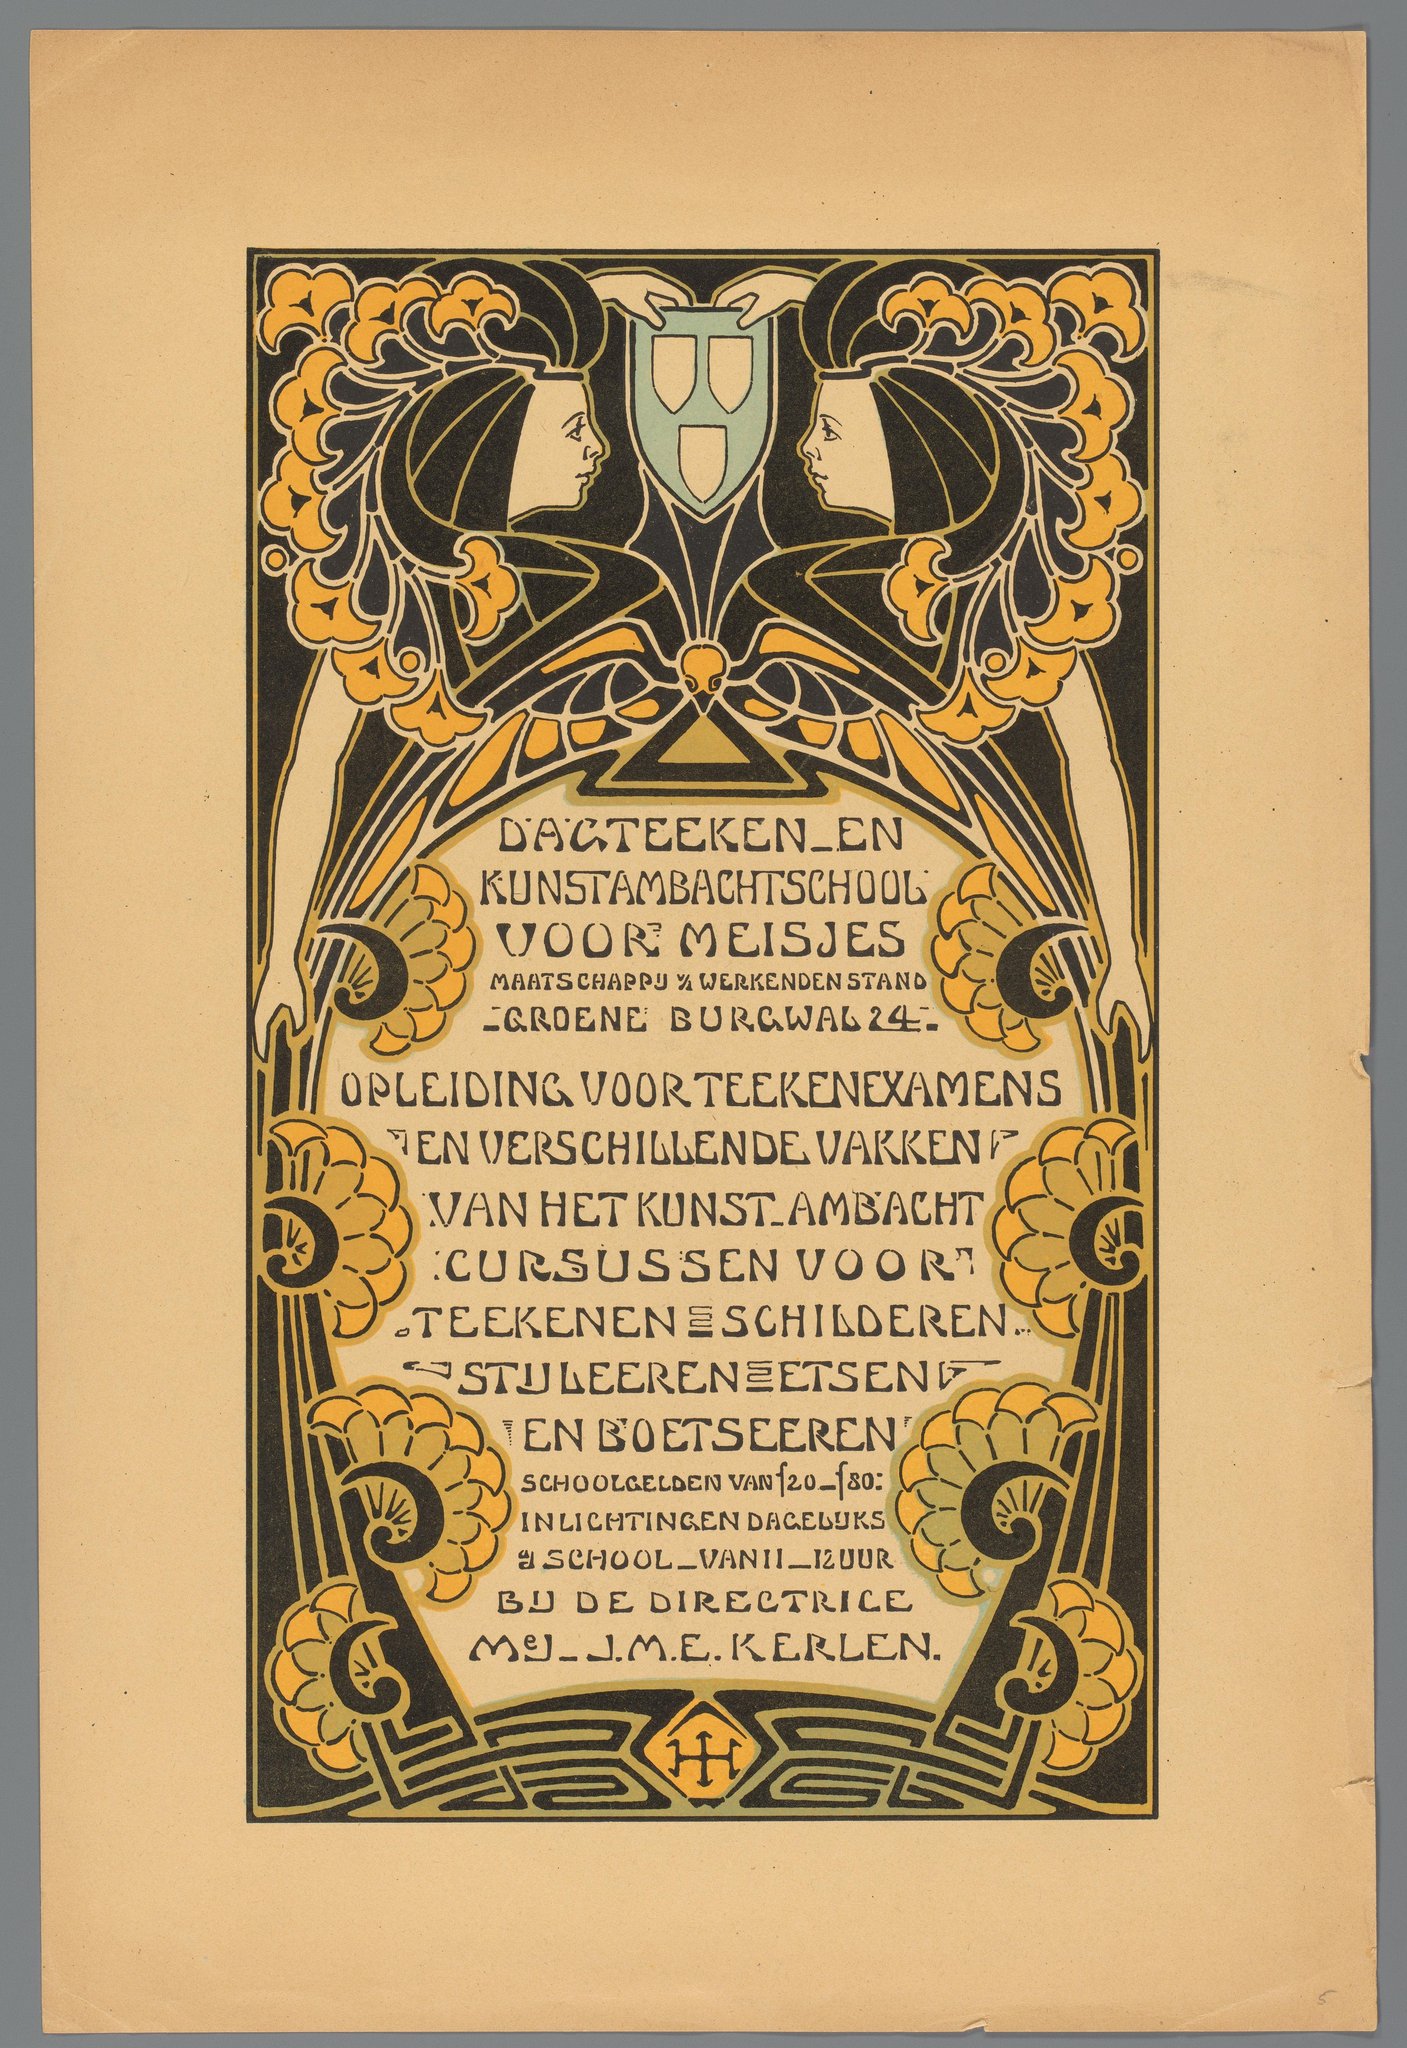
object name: poster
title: Affiche voor de Dagteeken- en Kunstambachtschool voor Meisjes van de Maatschappij voor den Werkenden Stand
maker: Anonymous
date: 1886-1916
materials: paper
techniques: lithograph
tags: the hague, face, ornaments ~ art, amsterdam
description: Bovenin twee vrouwengezichten tegenover elkaar met daaronder een decoratief kader met bloemmotieven en een vogel. Daarbinnen de tekst van de advertentie, met onder andere een opsomming van de beschikbare opleidingen en cursussen.